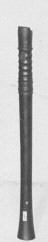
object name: alto recorder in f sharp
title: Alto Recorder in F-sharp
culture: german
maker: hieronimus franciscus kynseker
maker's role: maker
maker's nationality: german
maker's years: 1636-1686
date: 1601-1700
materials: horn, wood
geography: germany